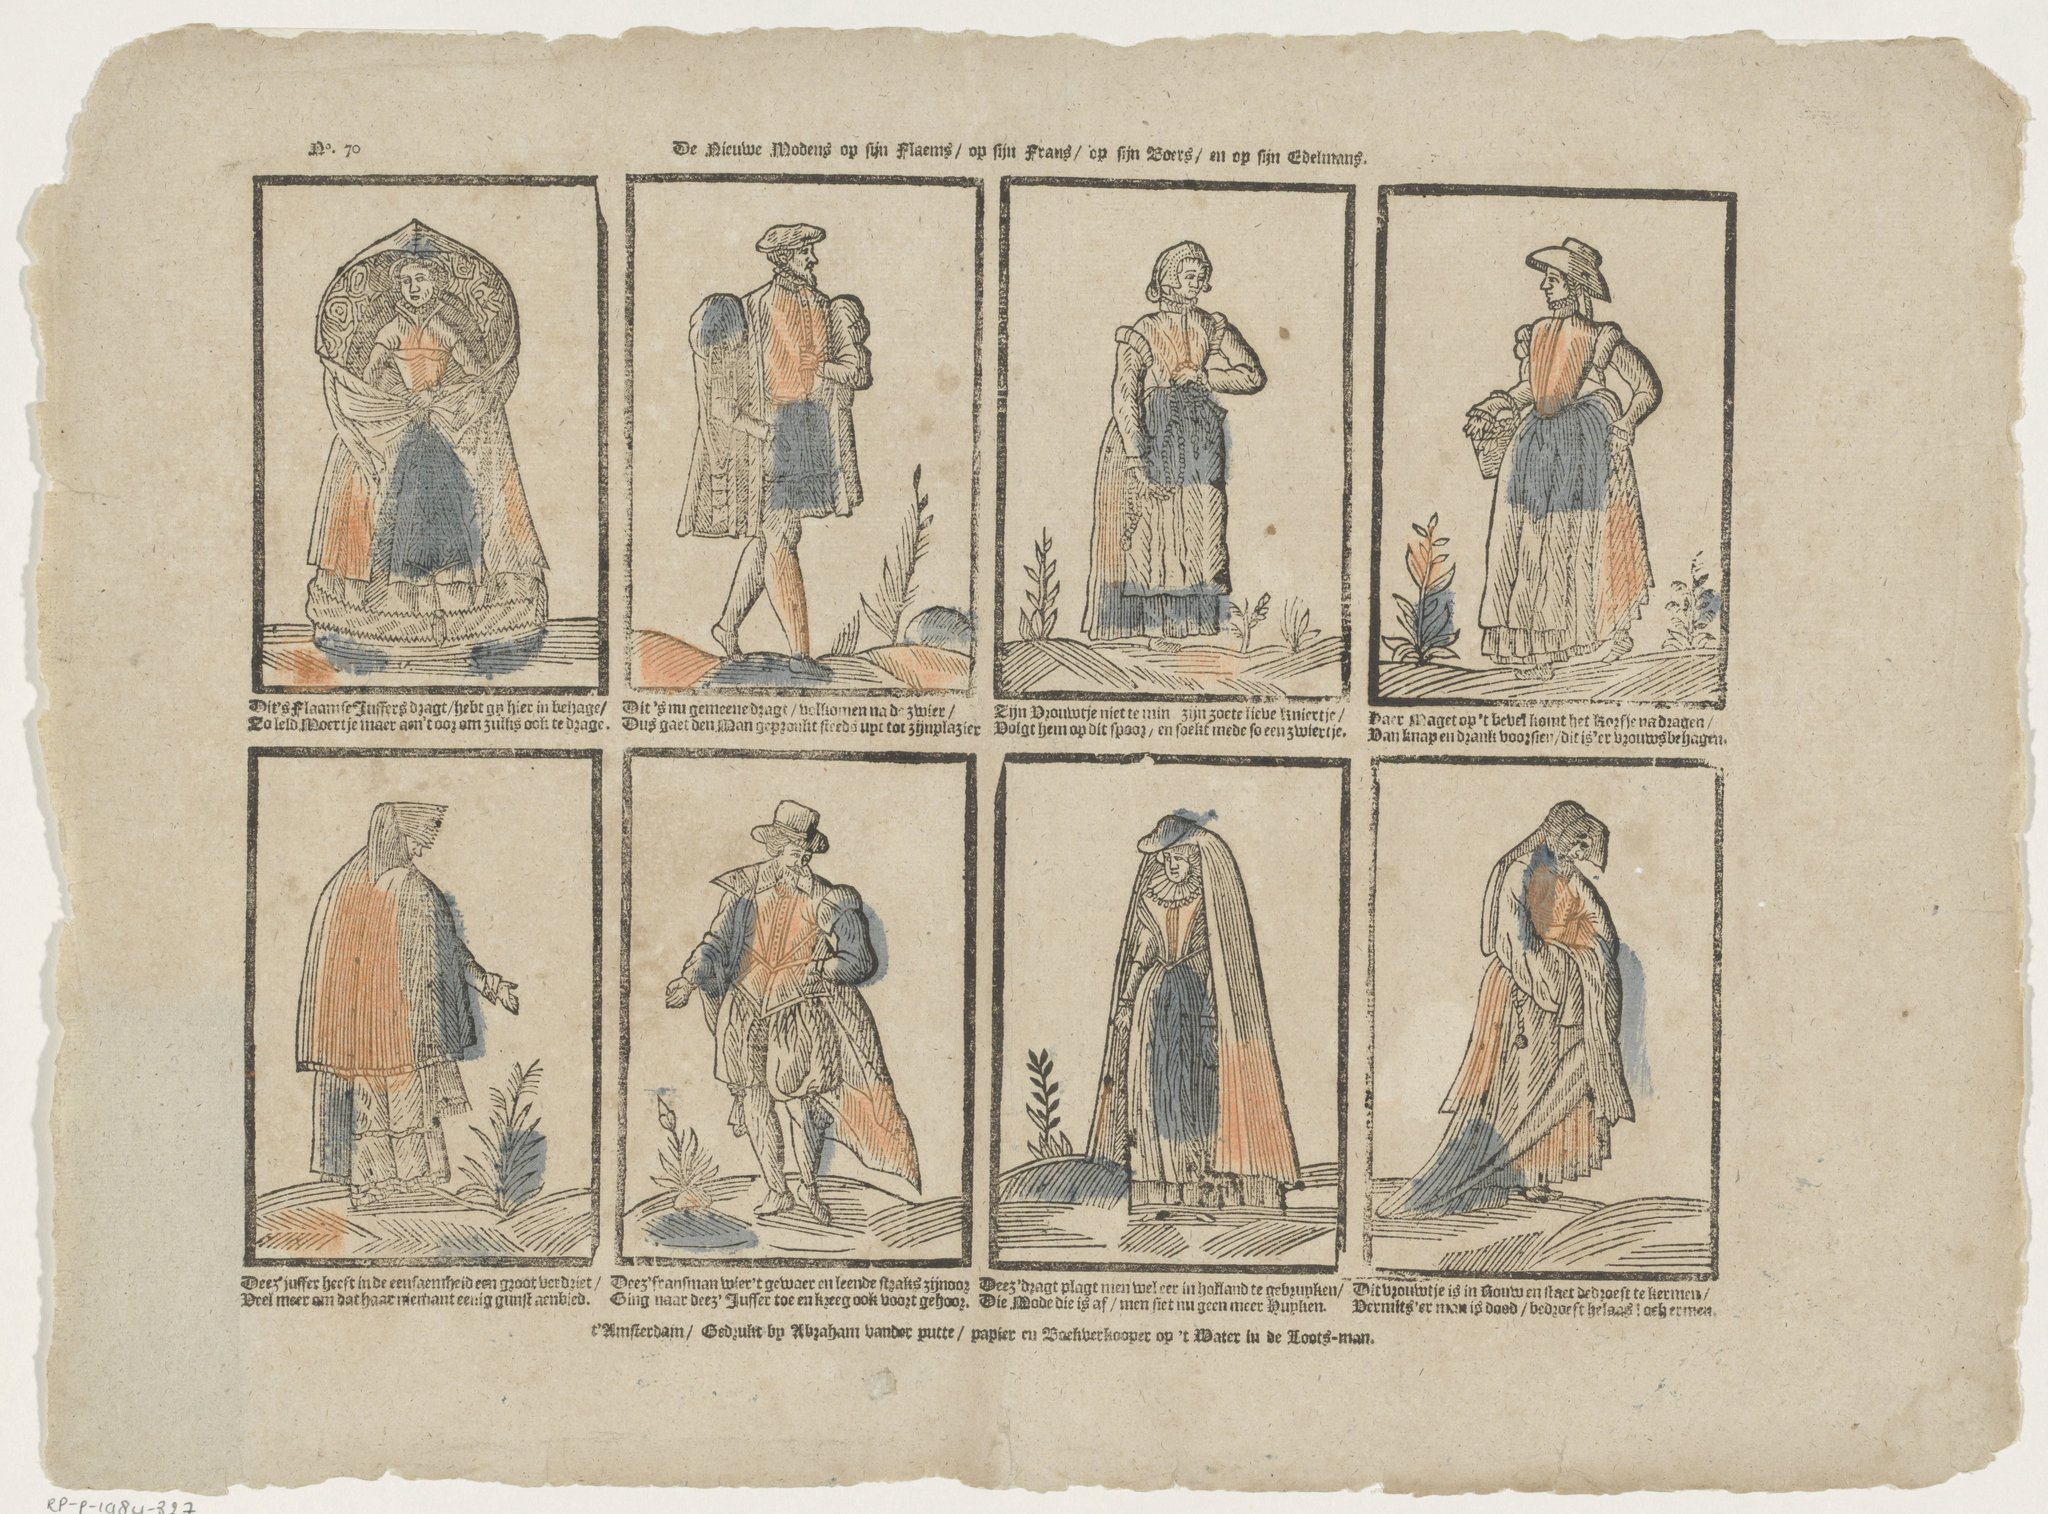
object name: popular print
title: De nieuwe modens op sijn Flaems / op sijn Frans / op sijn boers / en op sijn edelmans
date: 1748-1761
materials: paper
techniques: colour, letterpress printing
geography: amsterdam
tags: historical costume, folk costume, regional costume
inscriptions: collector's mark: Lugt 2228, collector's mark: Lugt 2760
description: Blad met 8 voorstellingen van mannen en vrouwen in verschillende klederdrachten. Onder elke afbeelding een tweeregelig vers. Genummerd linksboven: No. 70.